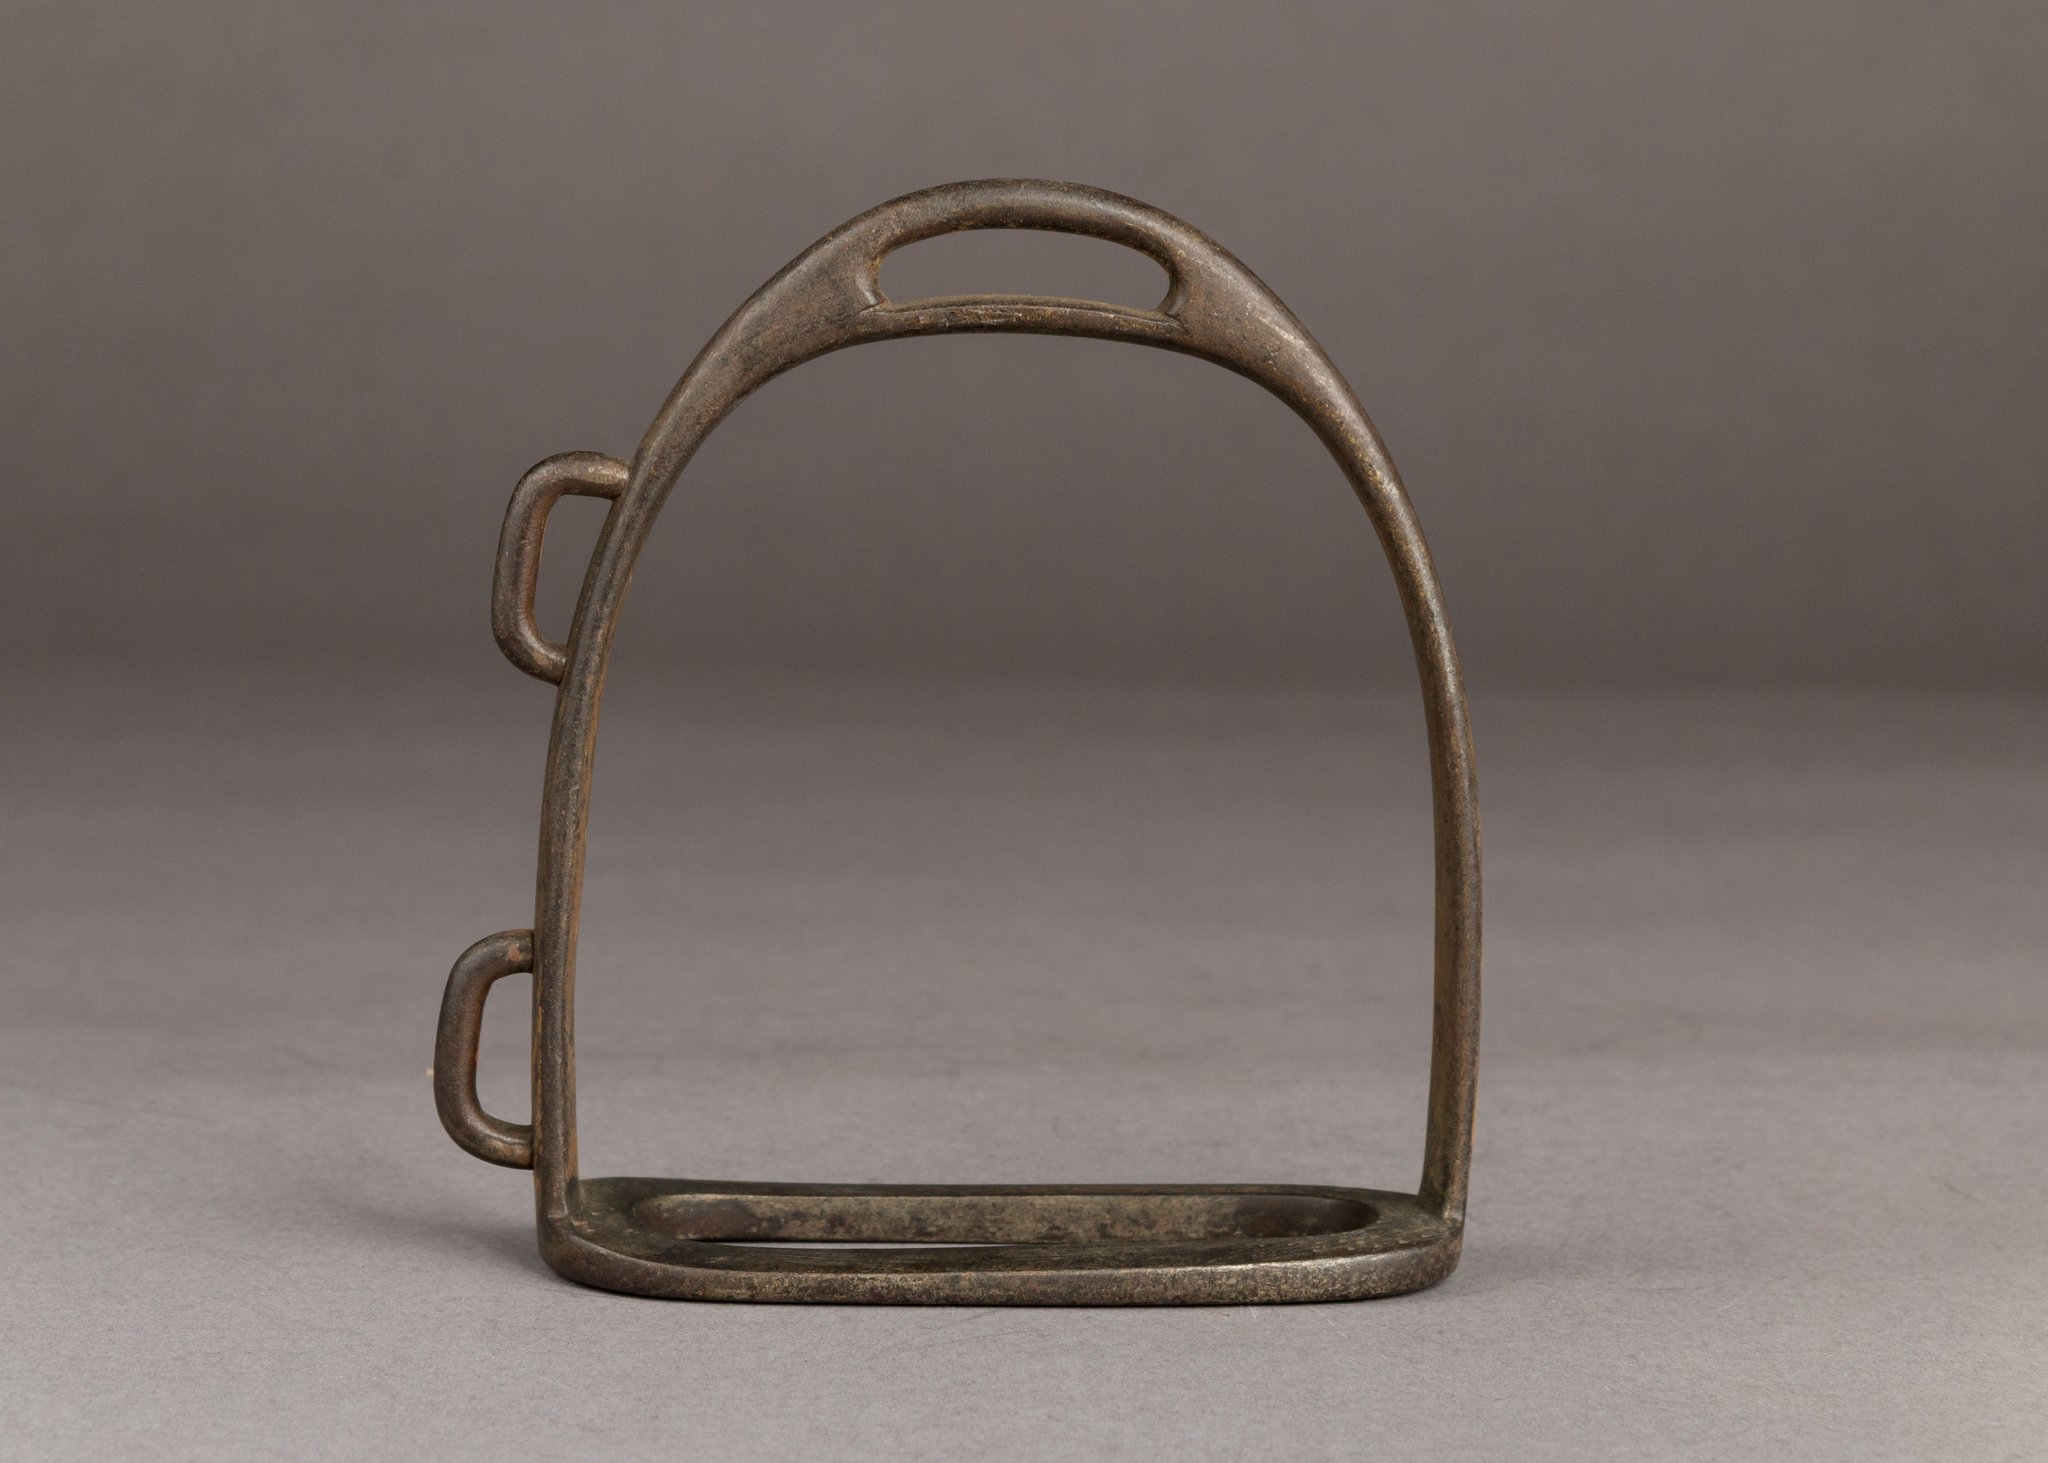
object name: stirrup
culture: indian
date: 1701-1900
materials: iron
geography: india